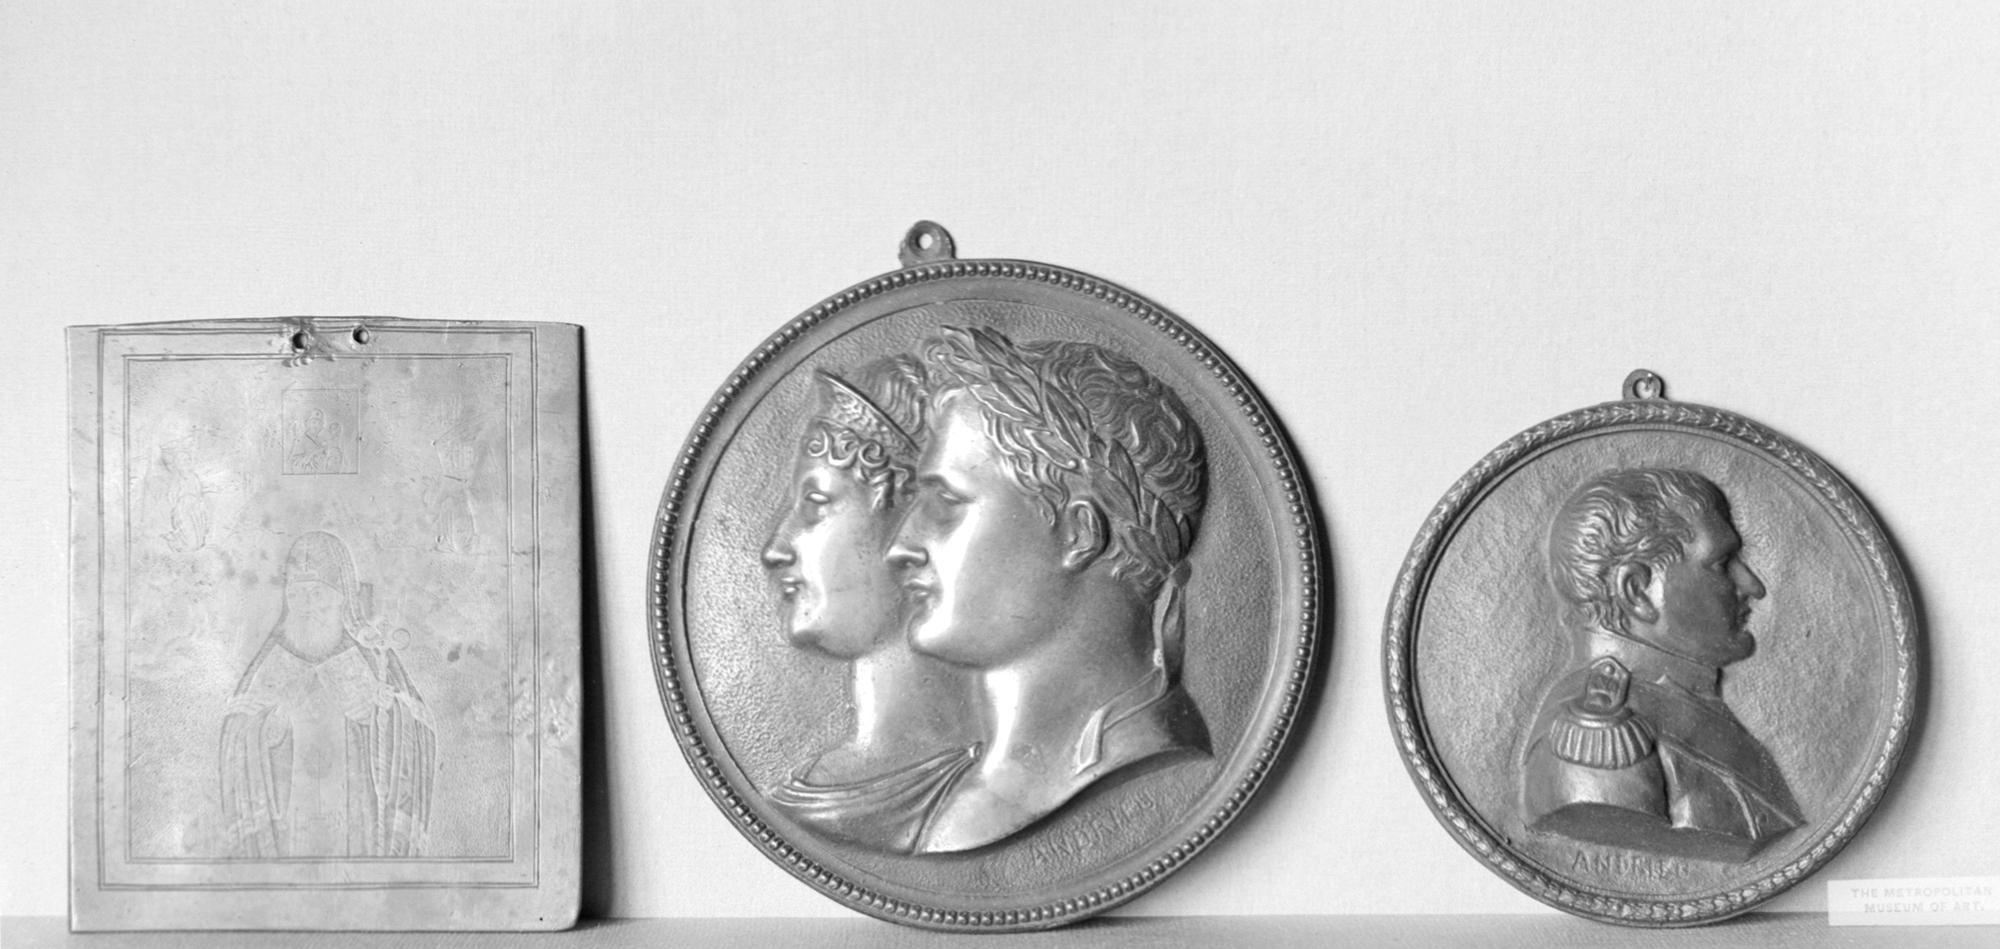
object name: medal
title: Medallion plaque to celebrate the marriage of Napoleon Bonaparte and the Archduchess Marie-Louise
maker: bertrand andrieu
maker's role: artist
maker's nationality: french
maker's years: 1761-1822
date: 1801-1900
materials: bronze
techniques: casting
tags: napoleon i,men,profiles,women